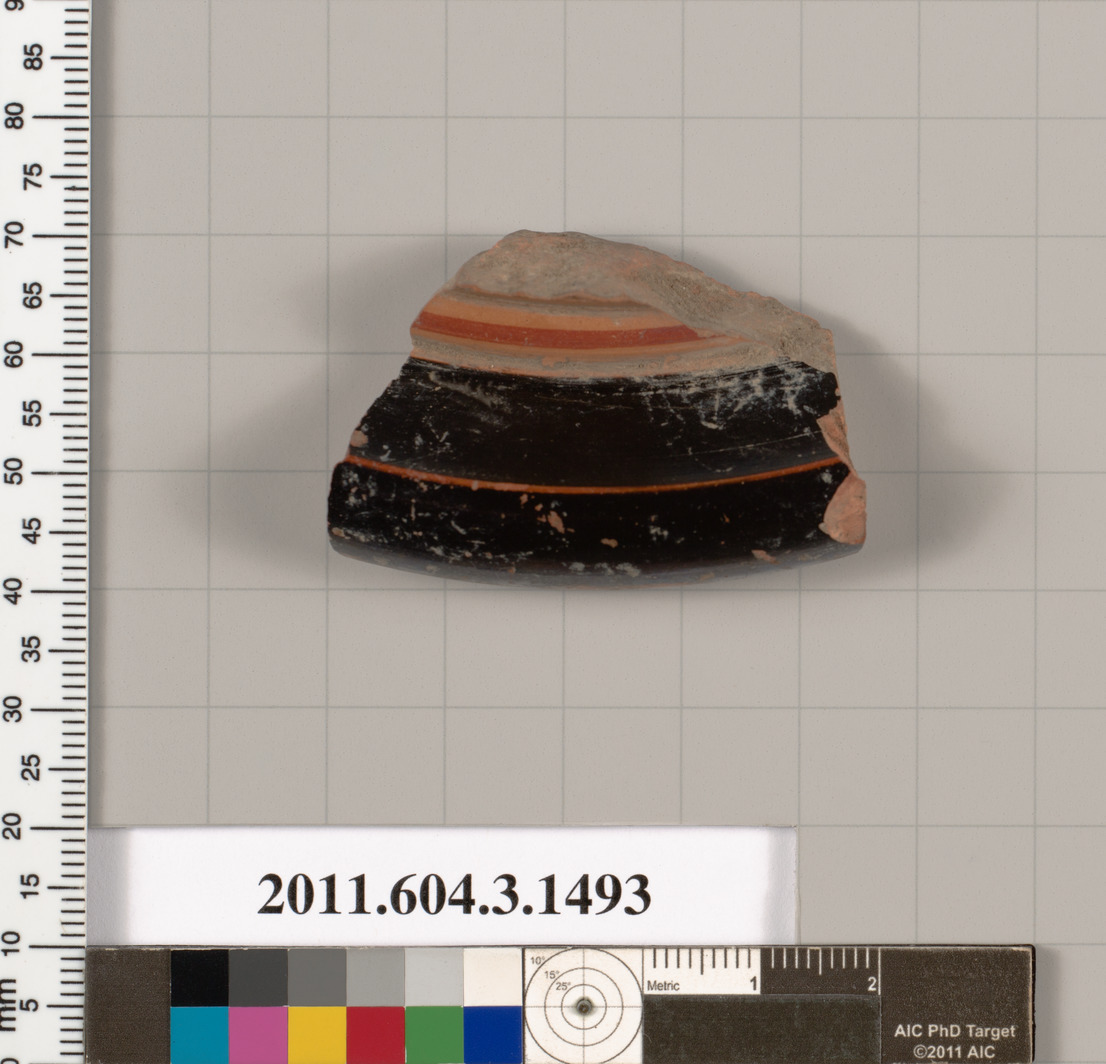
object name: skyphos fragment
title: Terracotta fragment of a skyphos (deep drinking cup)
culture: greek, attic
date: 600-401 BCE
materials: terracotta